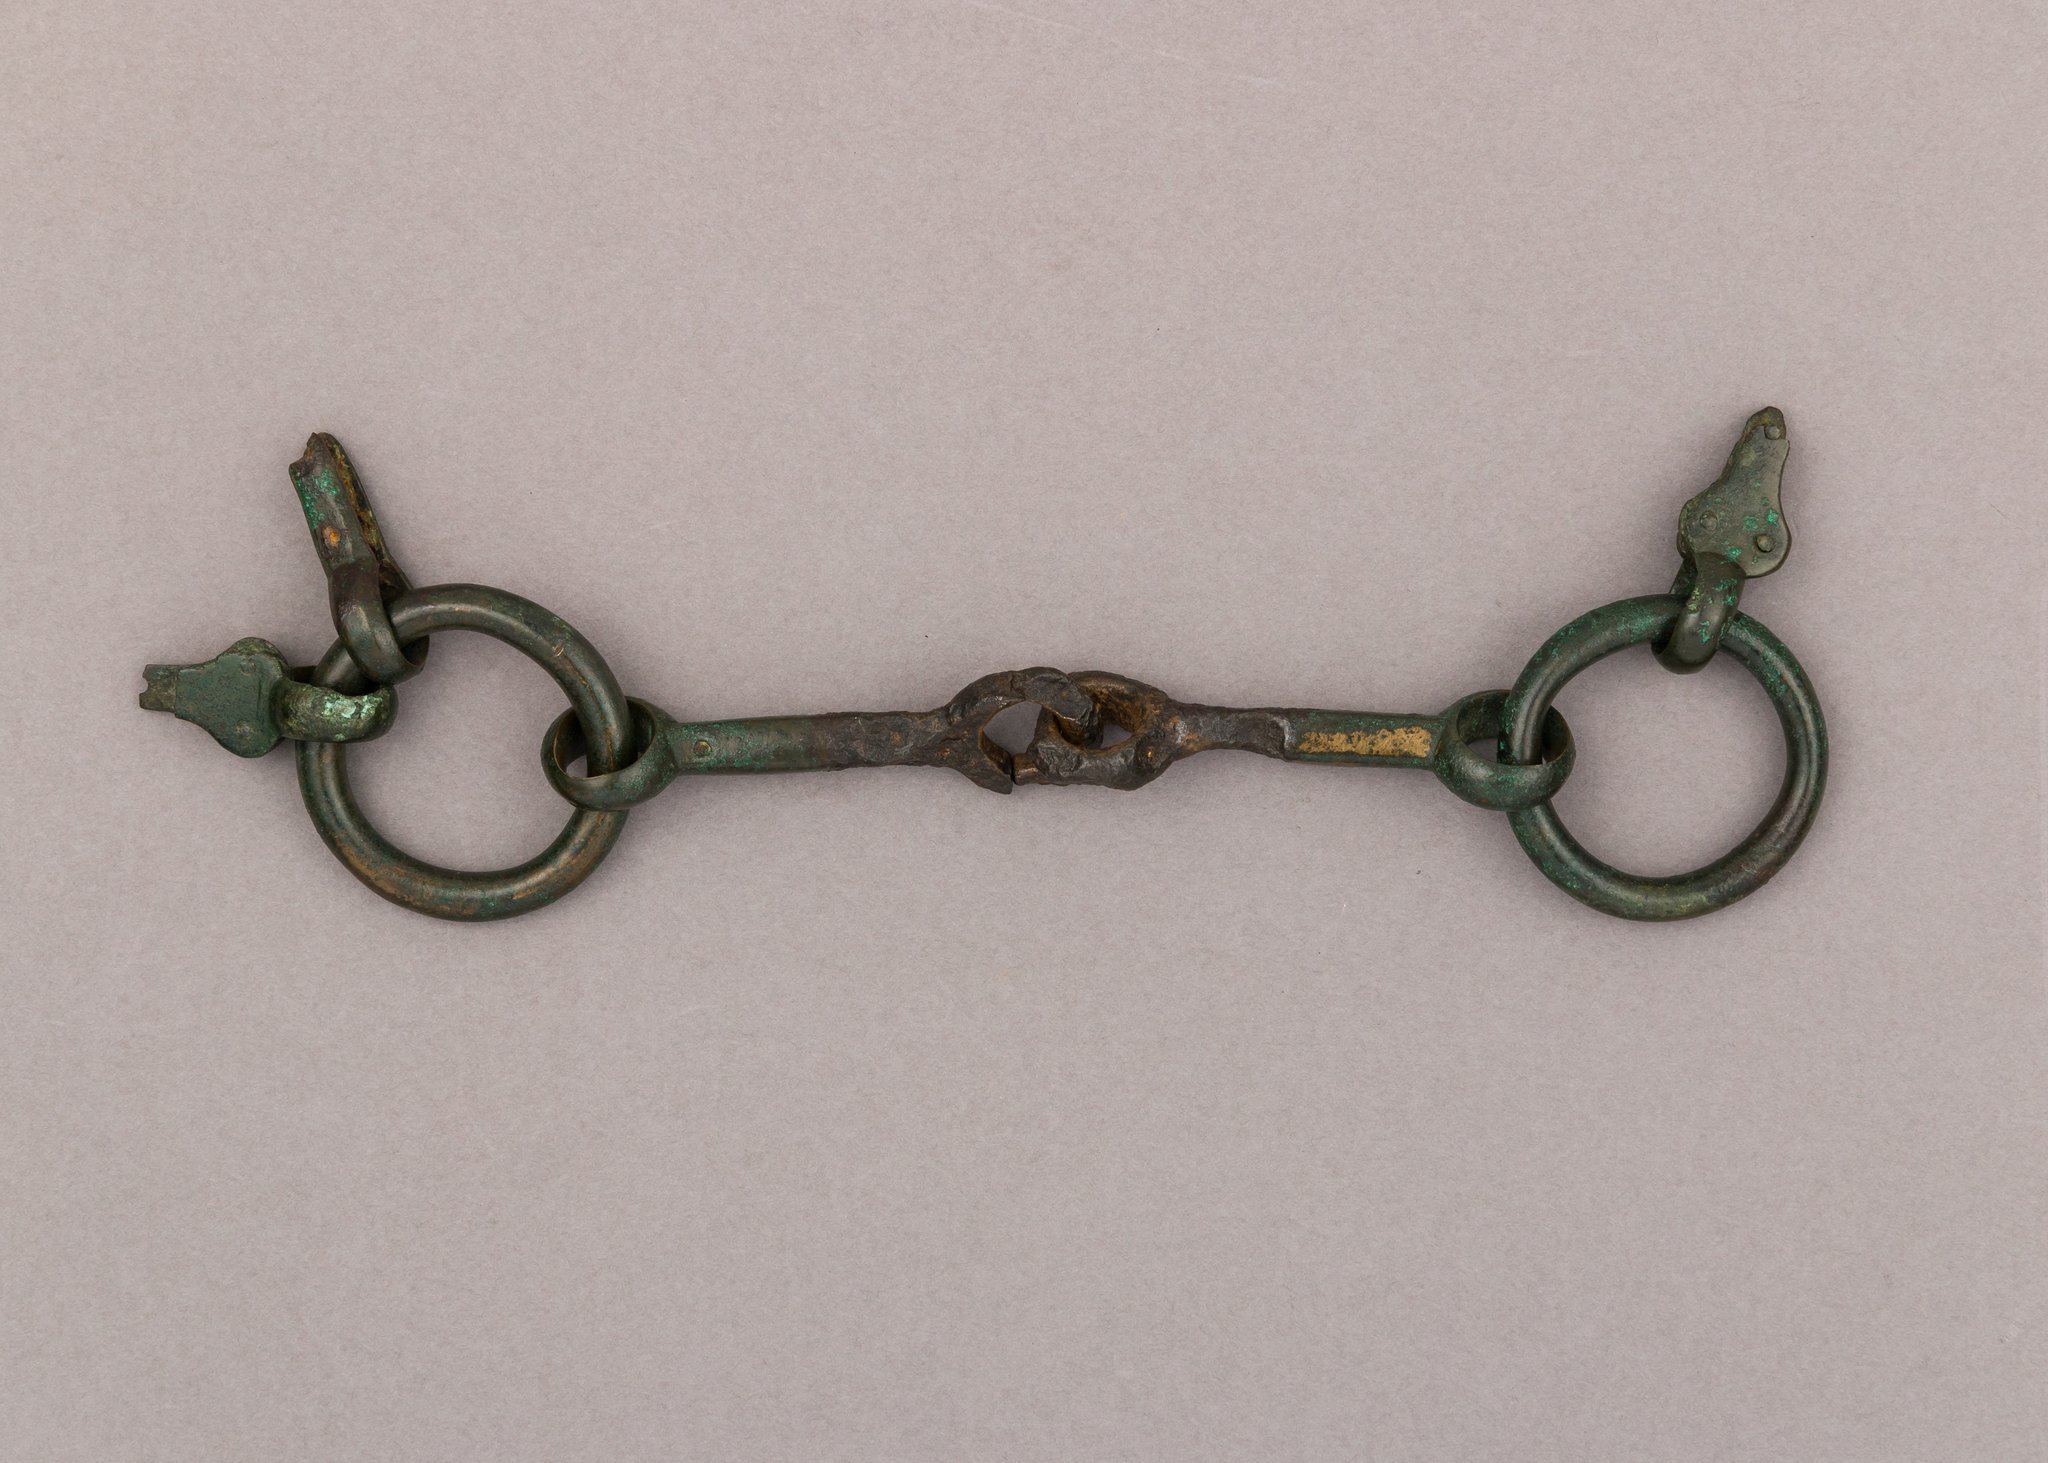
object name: bit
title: Snaffle Bit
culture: italian, lombardy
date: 301-500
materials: copper alloy, metal alloy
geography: italy